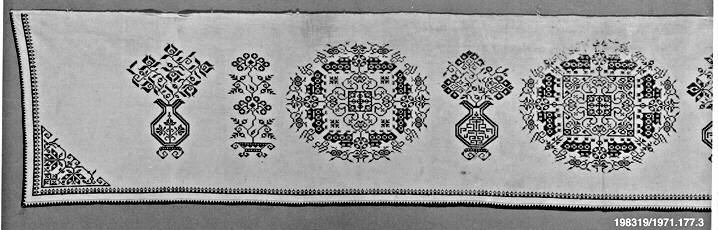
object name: valance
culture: chinese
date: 1801-1900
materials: cotton